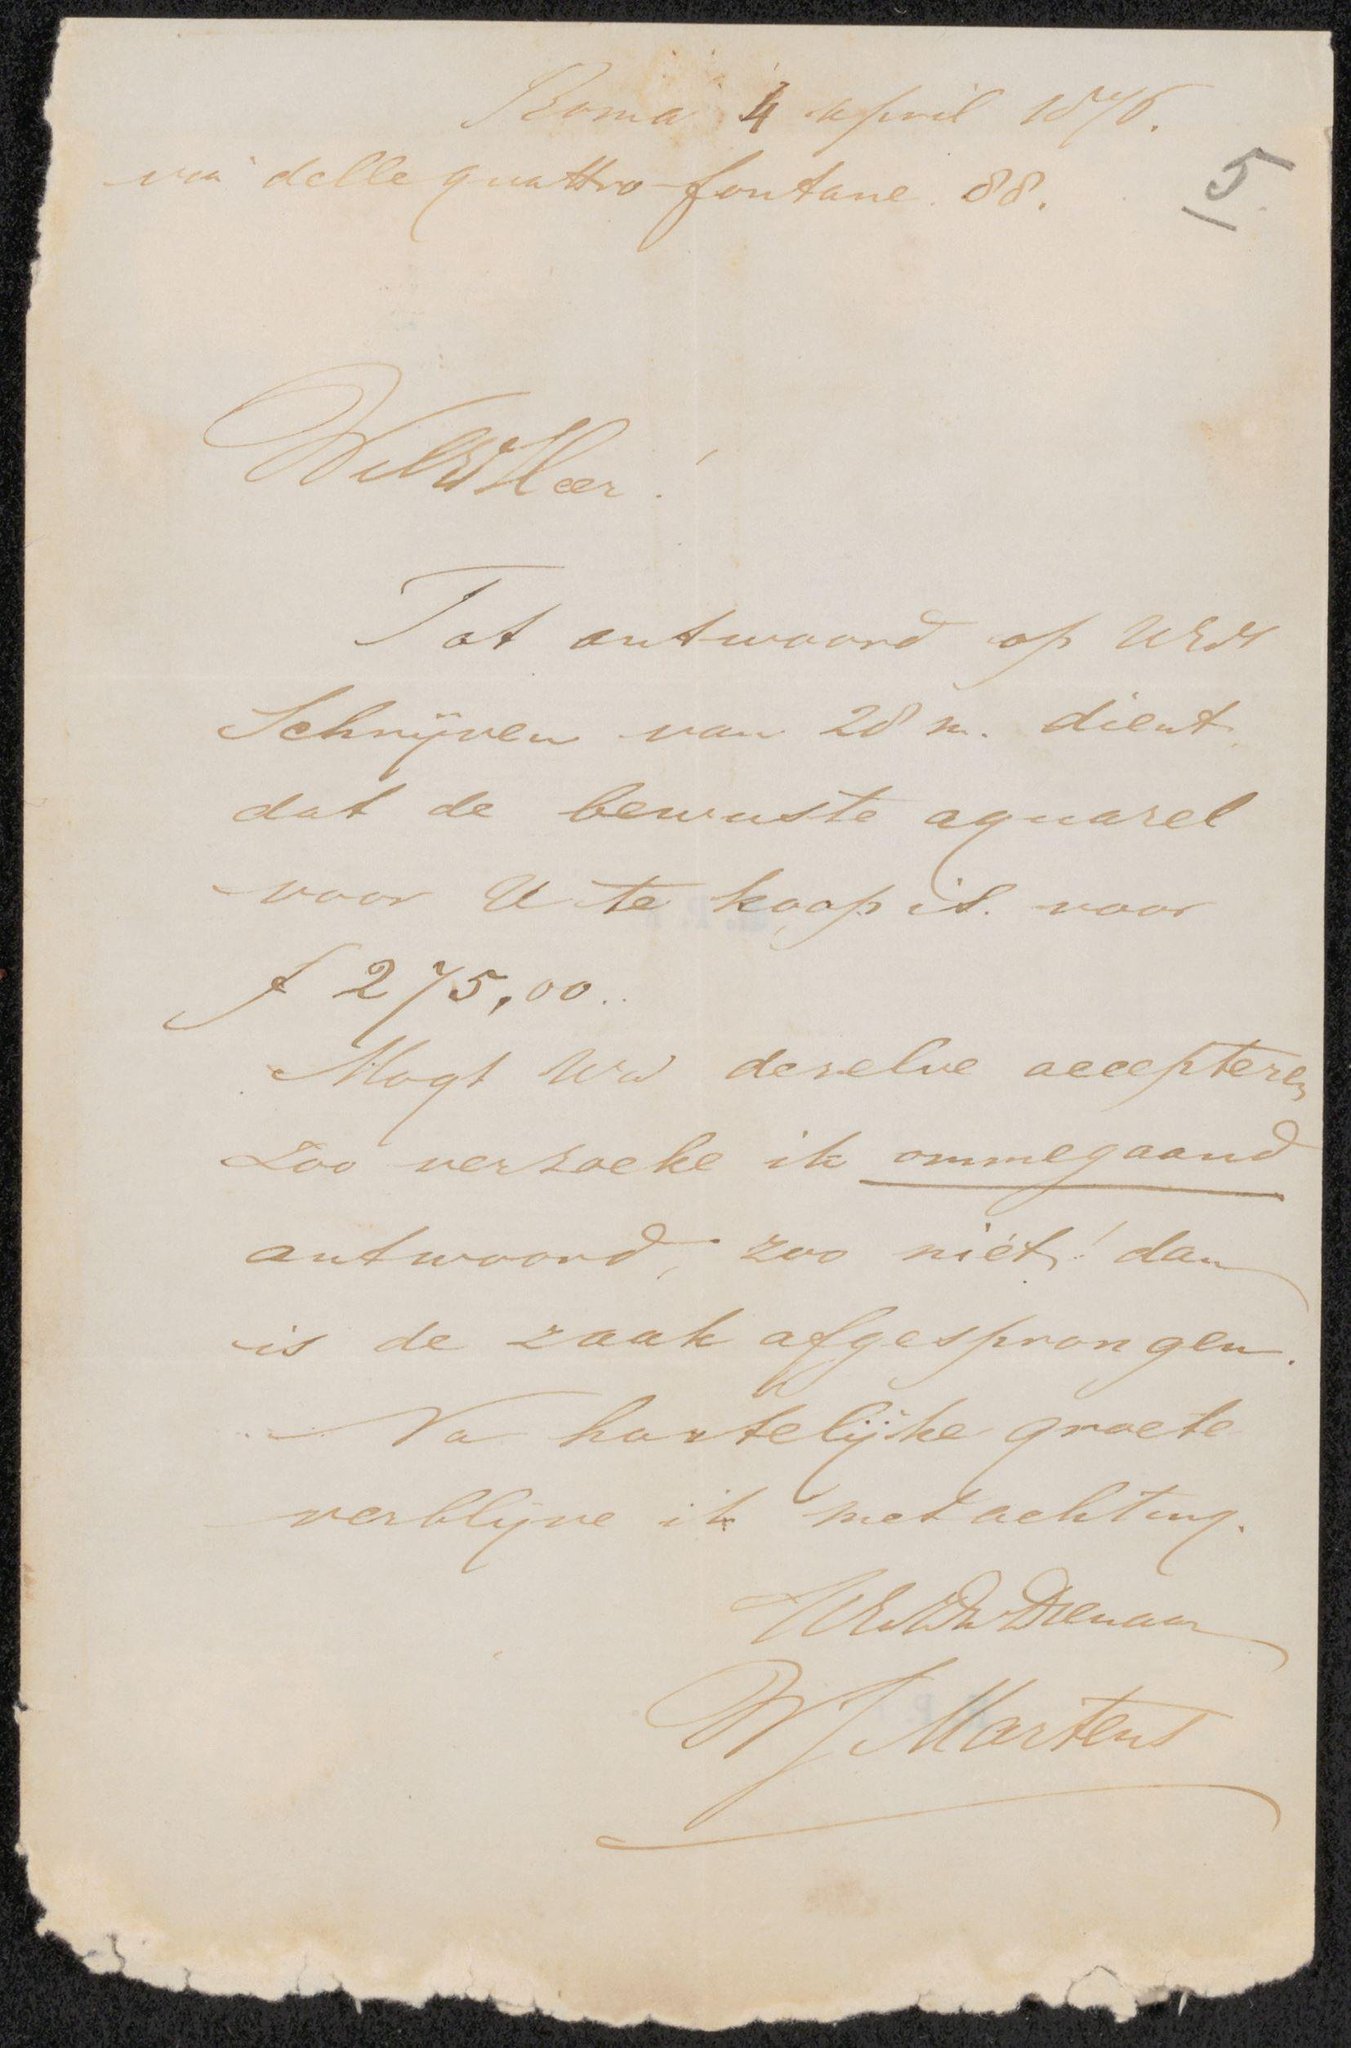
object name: letter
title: Brief aan anoniem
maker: willem johann martens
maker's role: draughtsman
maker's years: 1839-1895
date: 1876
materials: ink, paper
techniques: pen, writing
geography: rome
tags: art trade, art shop, drawing, money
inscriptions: collector's mark: Lugt 2233